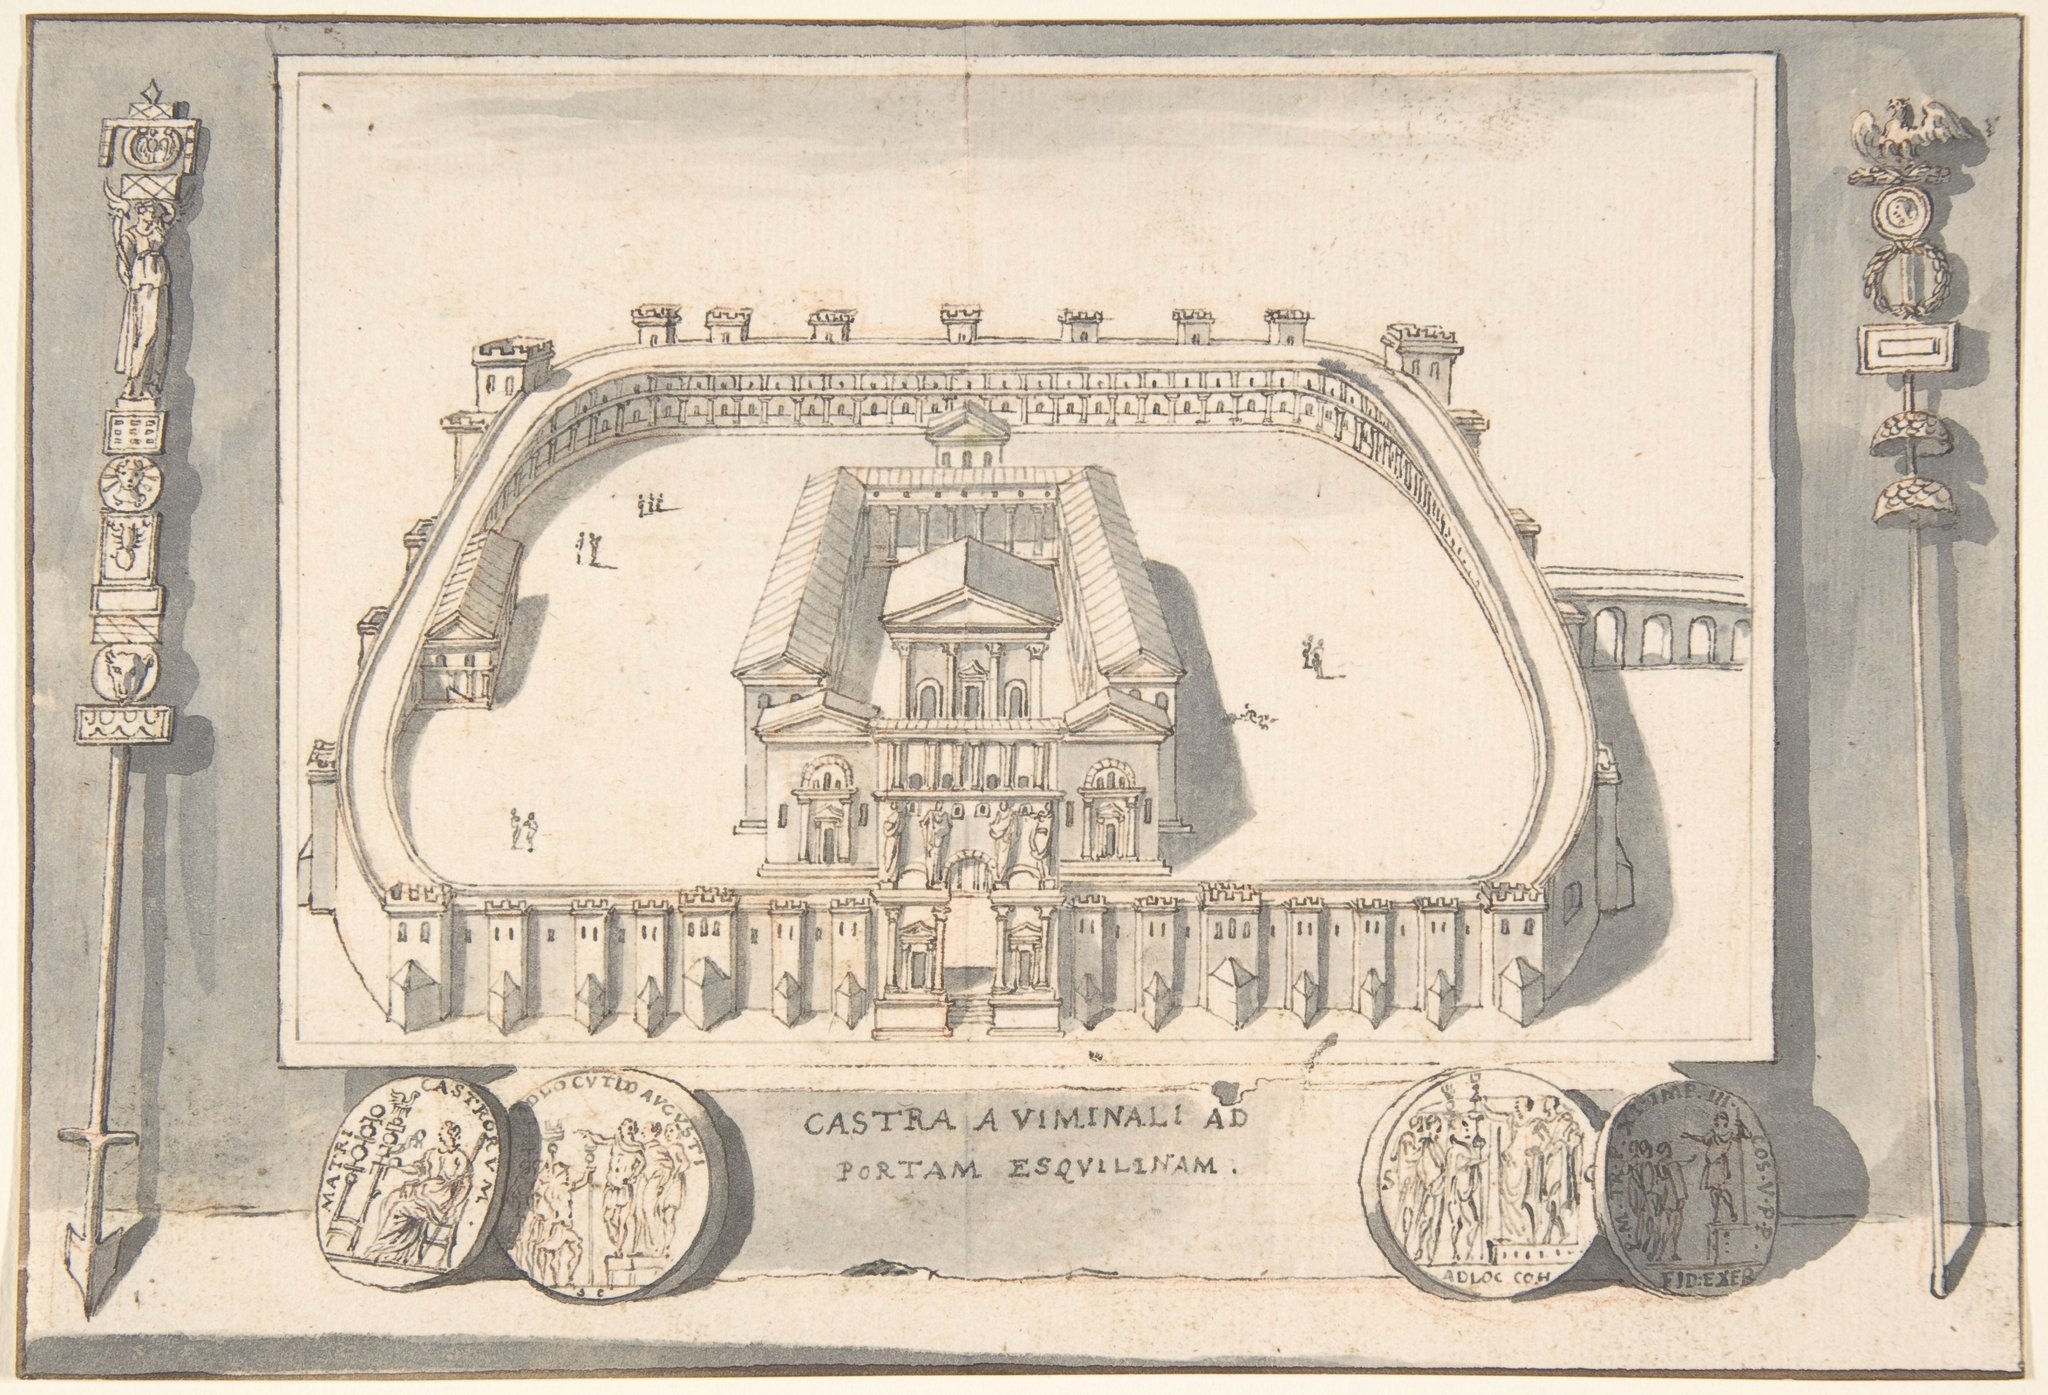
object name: drawing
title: A Reconstruction of a Castle on the Viminal Hill at the Esqualine Gate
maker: jan goeree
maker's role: artist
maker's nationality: dutch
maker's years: 1670-1731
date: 1704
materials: chalk, ink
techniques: brush, pen, wash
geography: italy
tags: castles